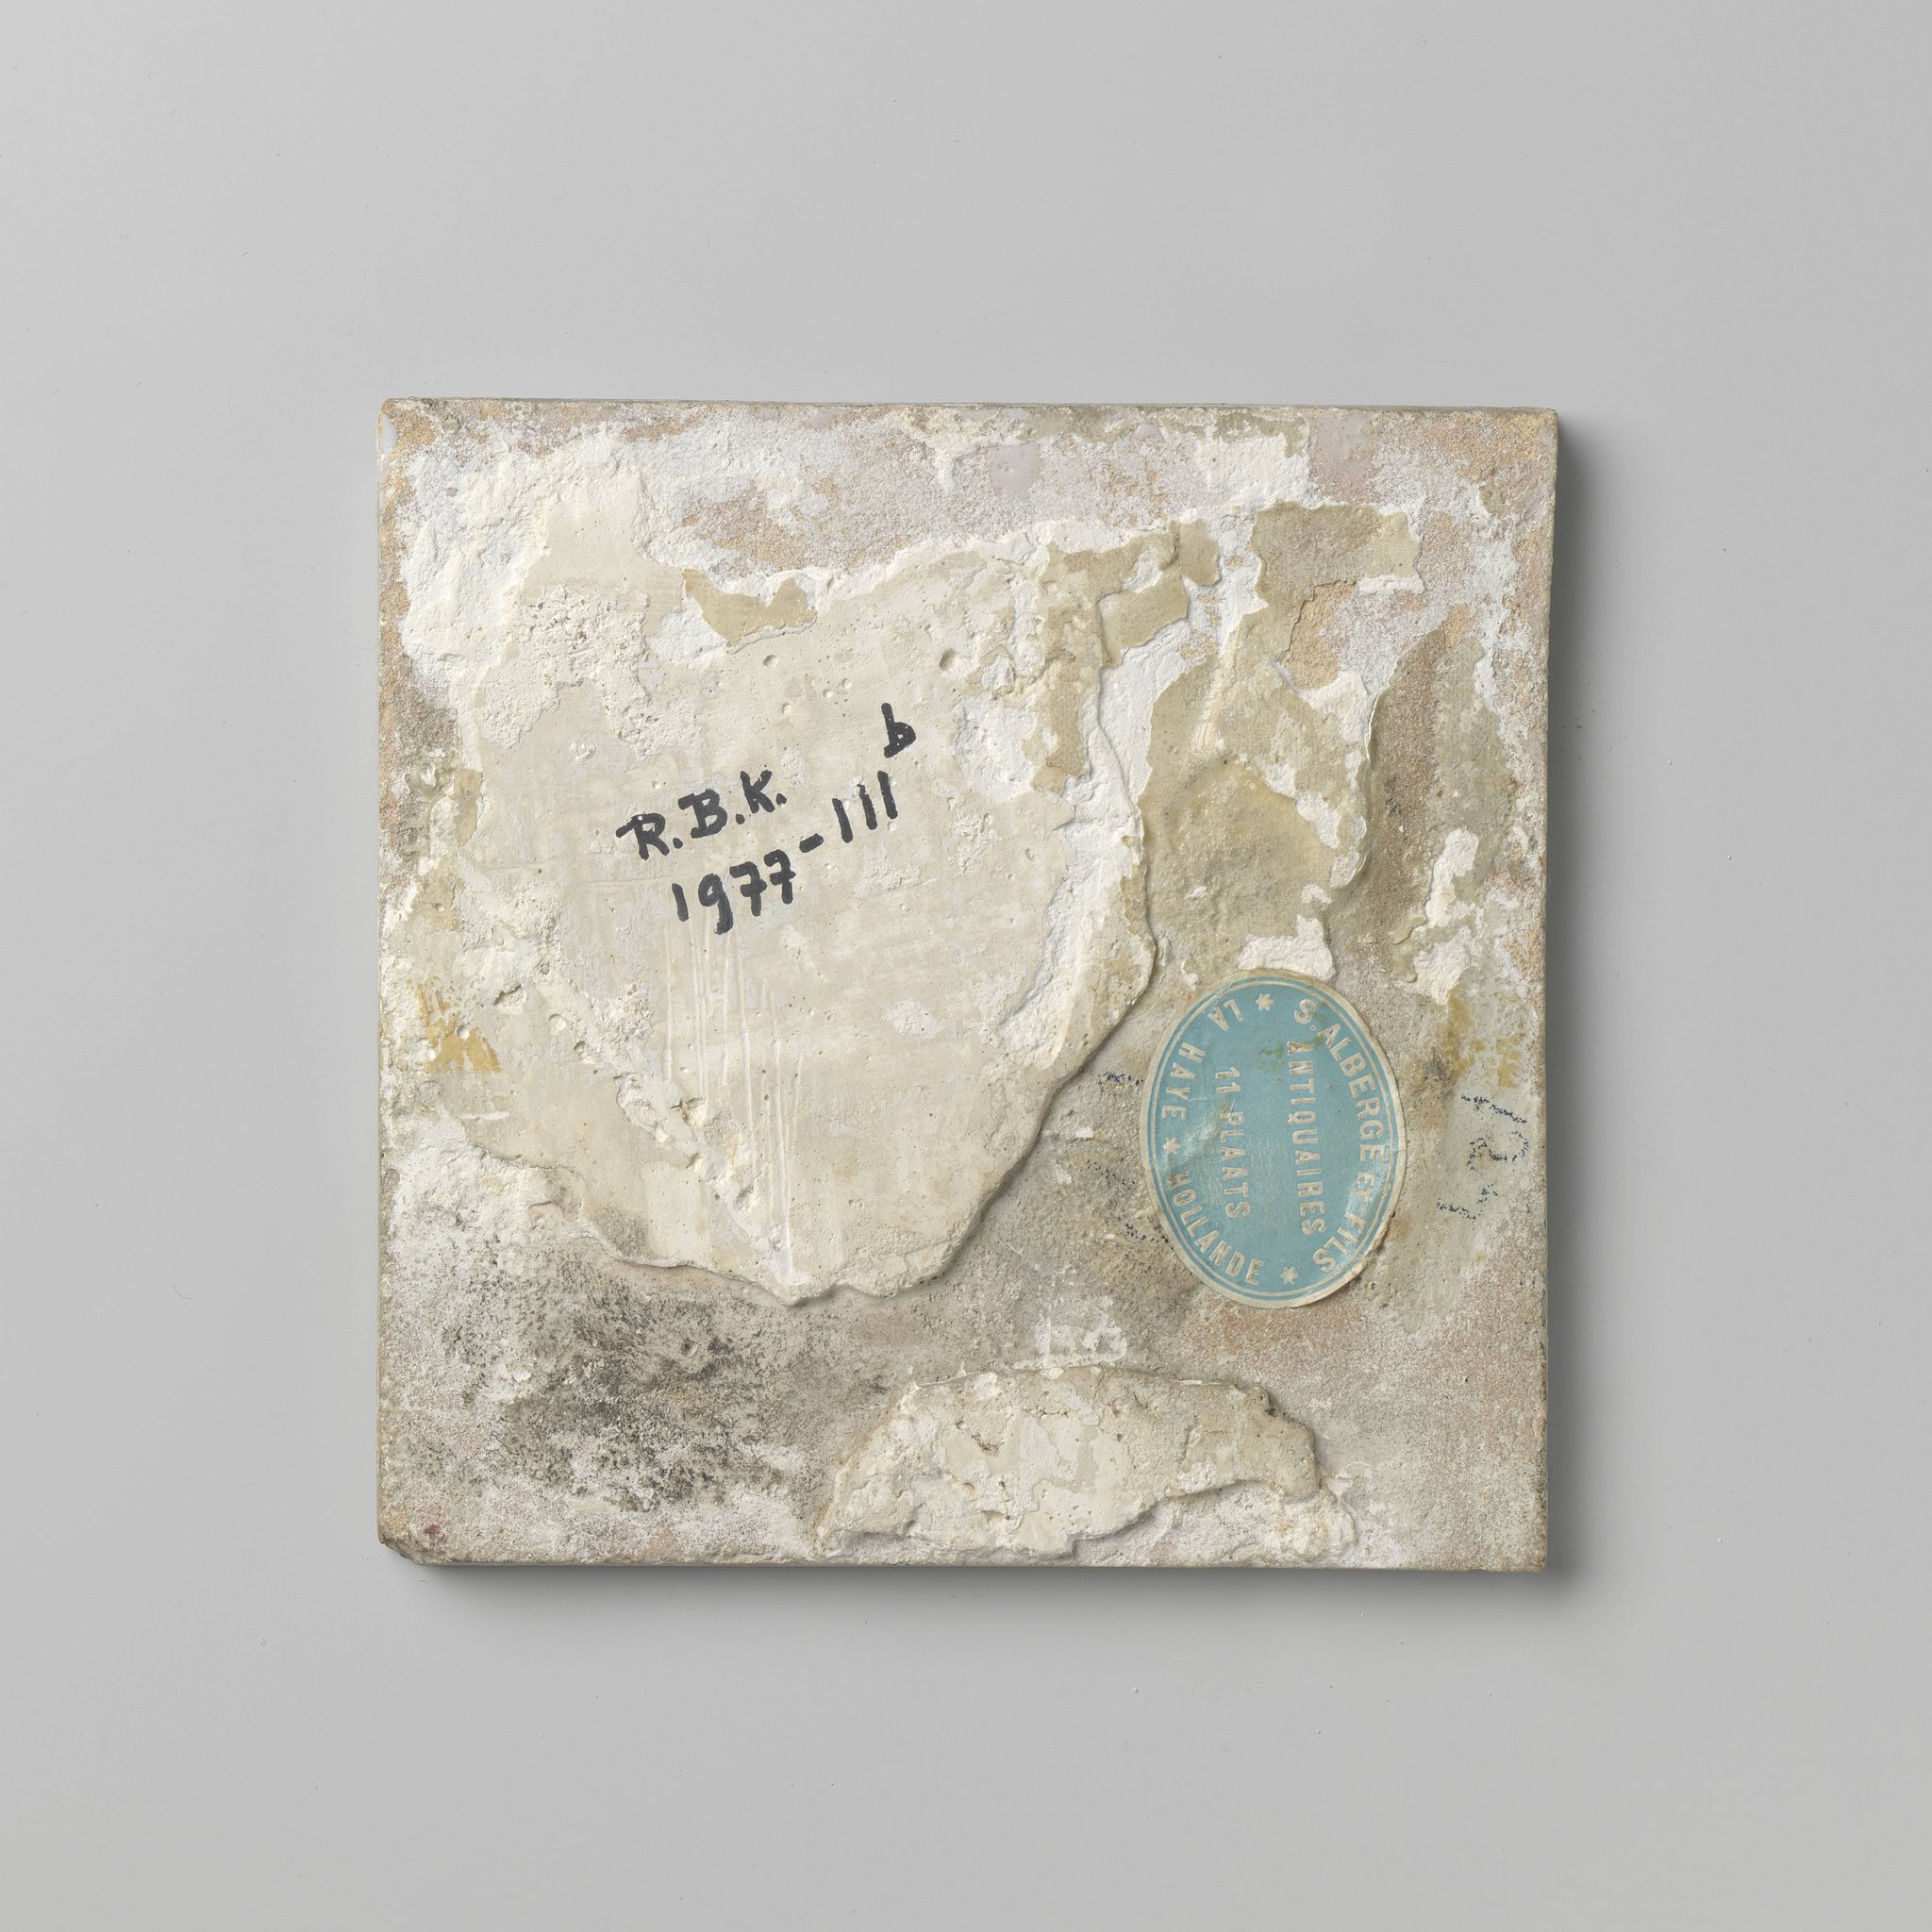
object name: tile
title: Tegel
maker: Anonymous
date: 1720-1760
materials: earthenware, glaze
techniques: maiolica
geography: netherlands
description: Tegel met een veelkleurige (blauw, rood en groen) bloemvaas met aan weerszijden een vogel binnen een achthoek omgeven door gesprenkeld groen. In de hoeken, rode uitgespaarde anjers.